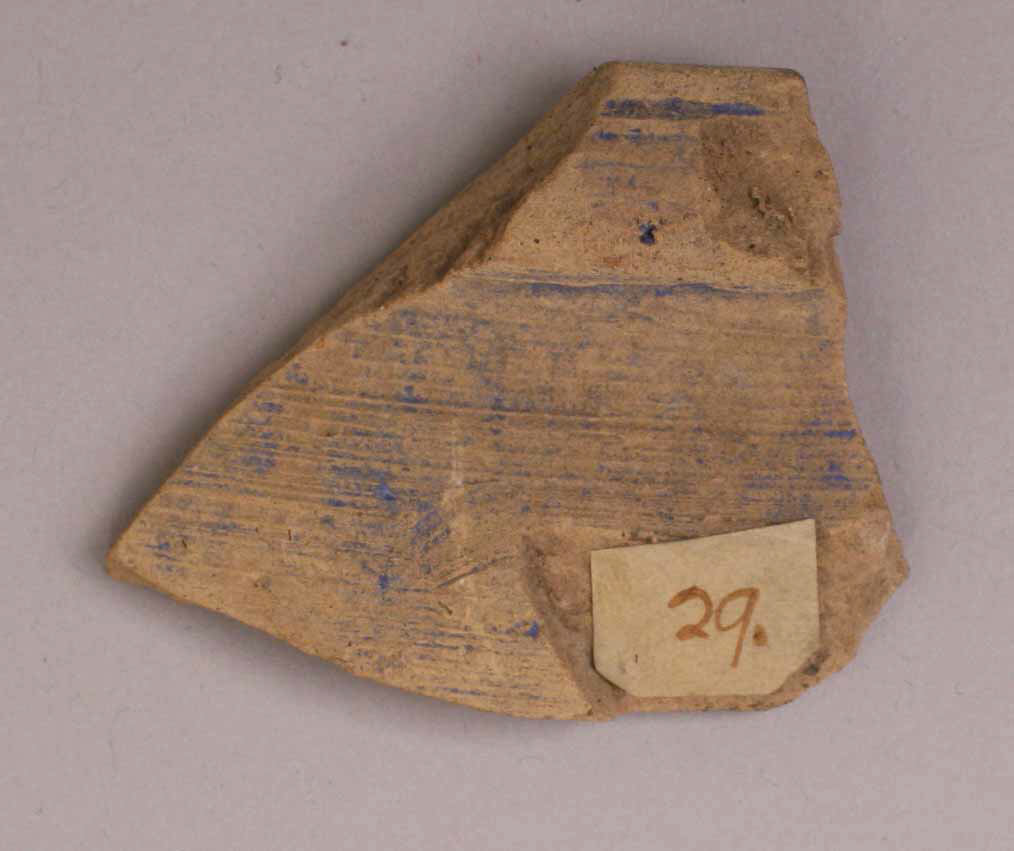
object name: fragment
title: Ceramic Fragment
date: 801-900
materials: earthenware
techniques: glazing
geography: iraq